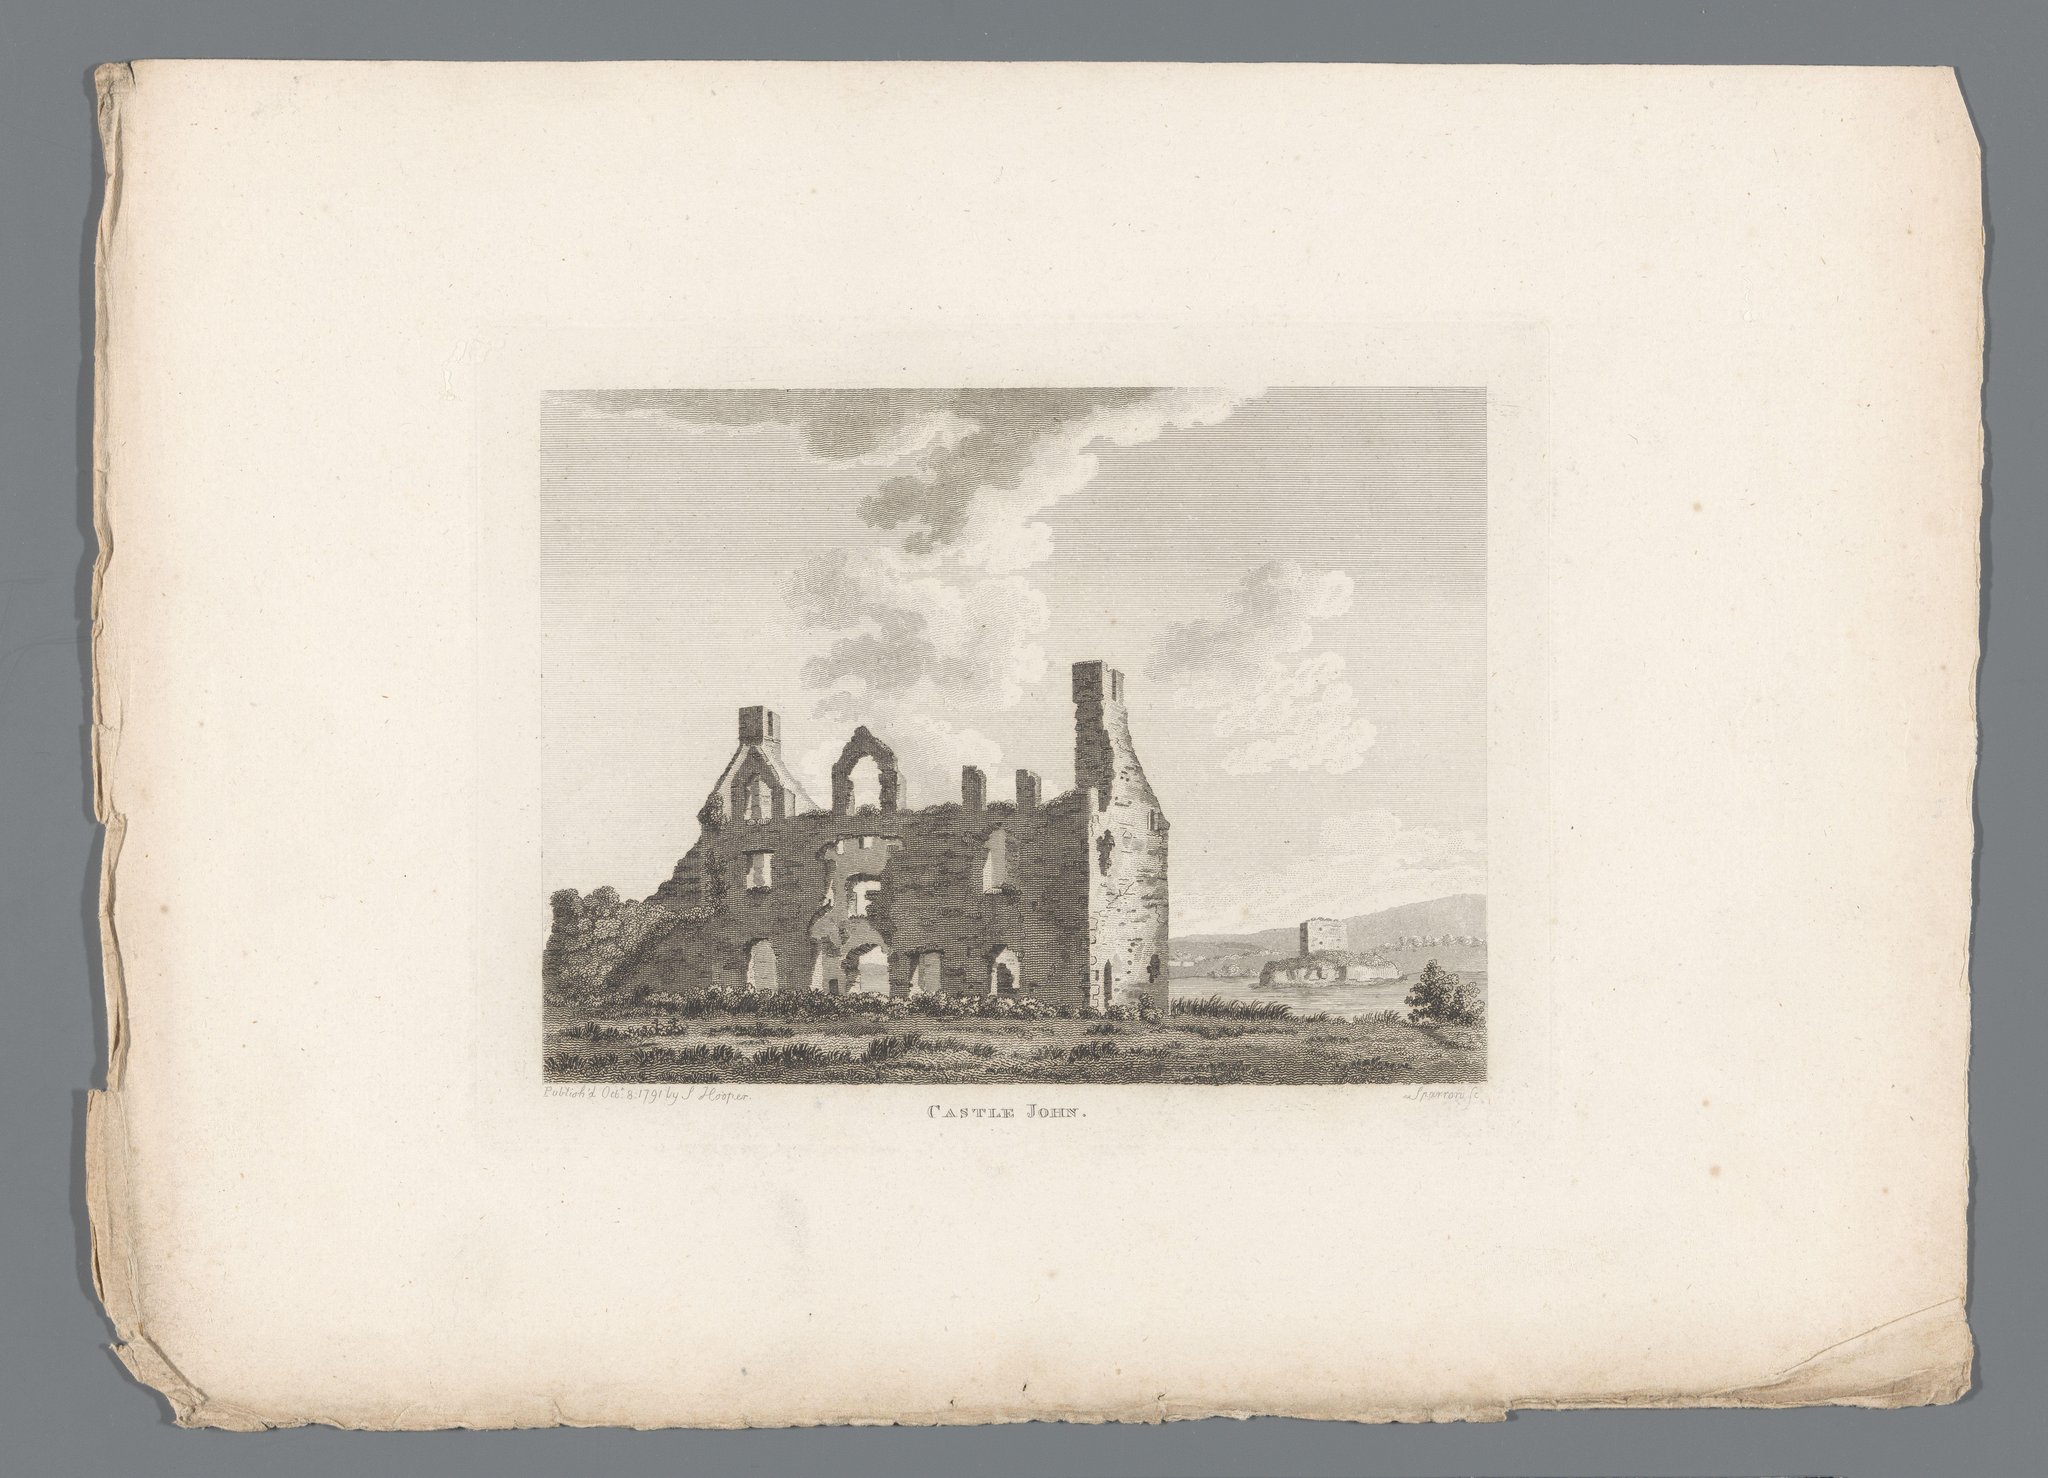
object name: print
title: Gezicht op de ruïnes van Sint-Johns Castle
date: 1791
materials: paper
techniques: etching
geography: london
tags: landscape with ruins, landscape with tower or castle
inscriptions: date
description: Prent verschenen in: Grose, Francis. The antiquities of Ireland. Londen: S. Hooper, 1795, dl. 2.